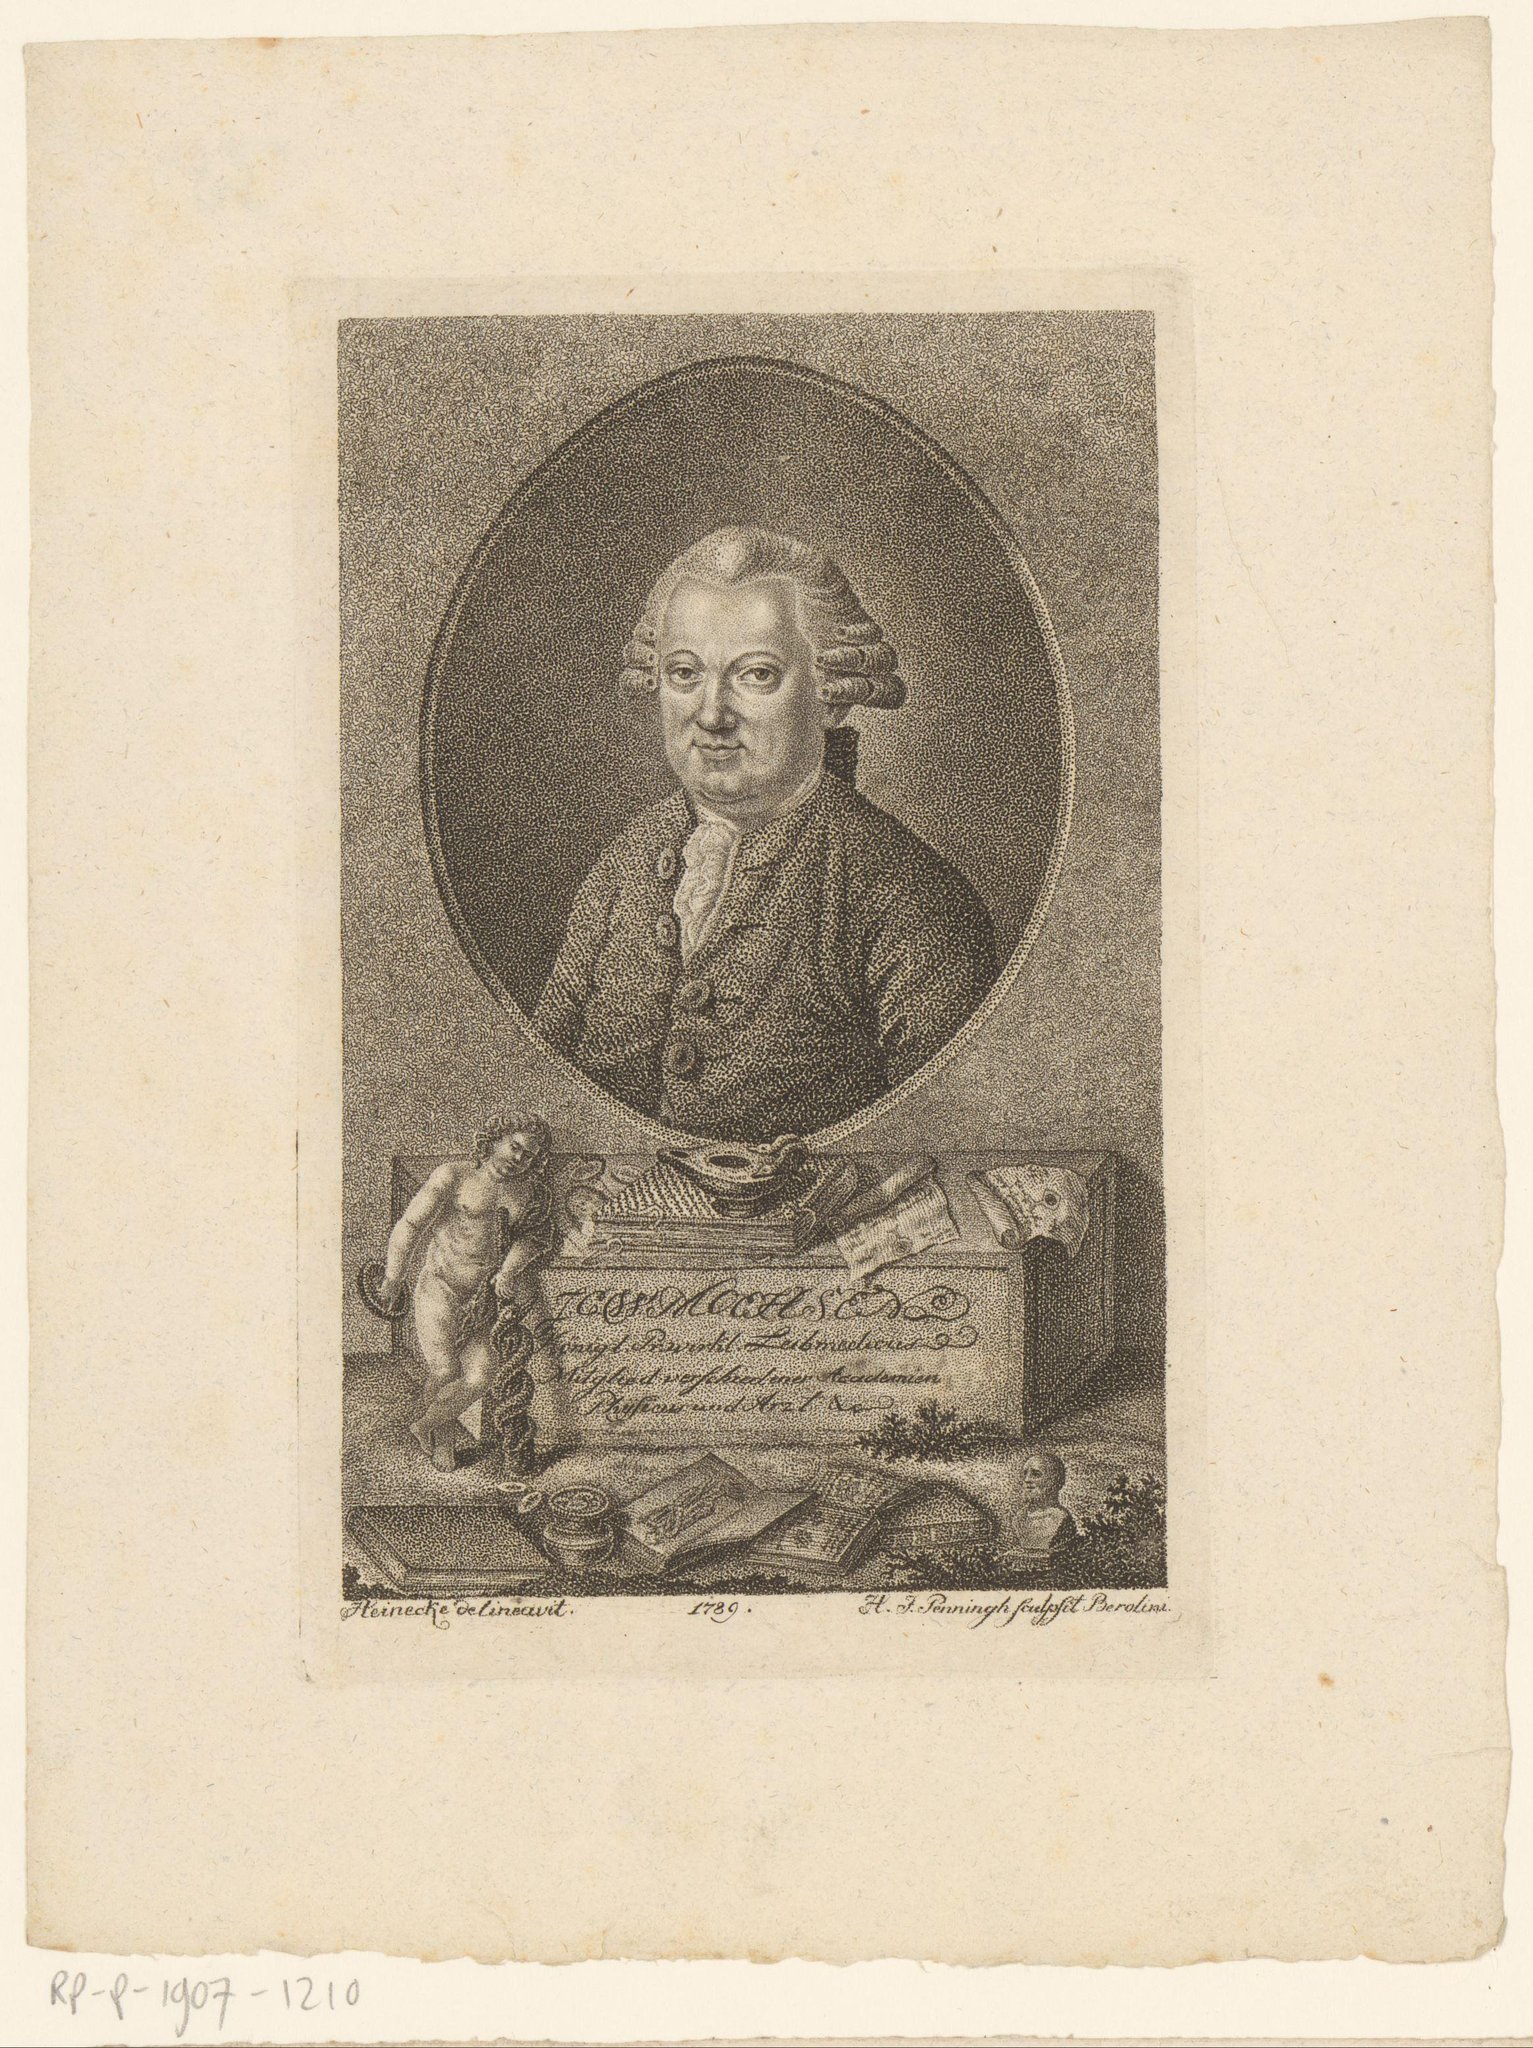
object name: print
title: Portret van Johann Carl Wilhelm Moehsen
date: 1789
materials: paper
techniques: stippled etching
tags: berlin, historical persons, medical research, branches of medicine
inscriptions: collector's mark: Lugt 2228